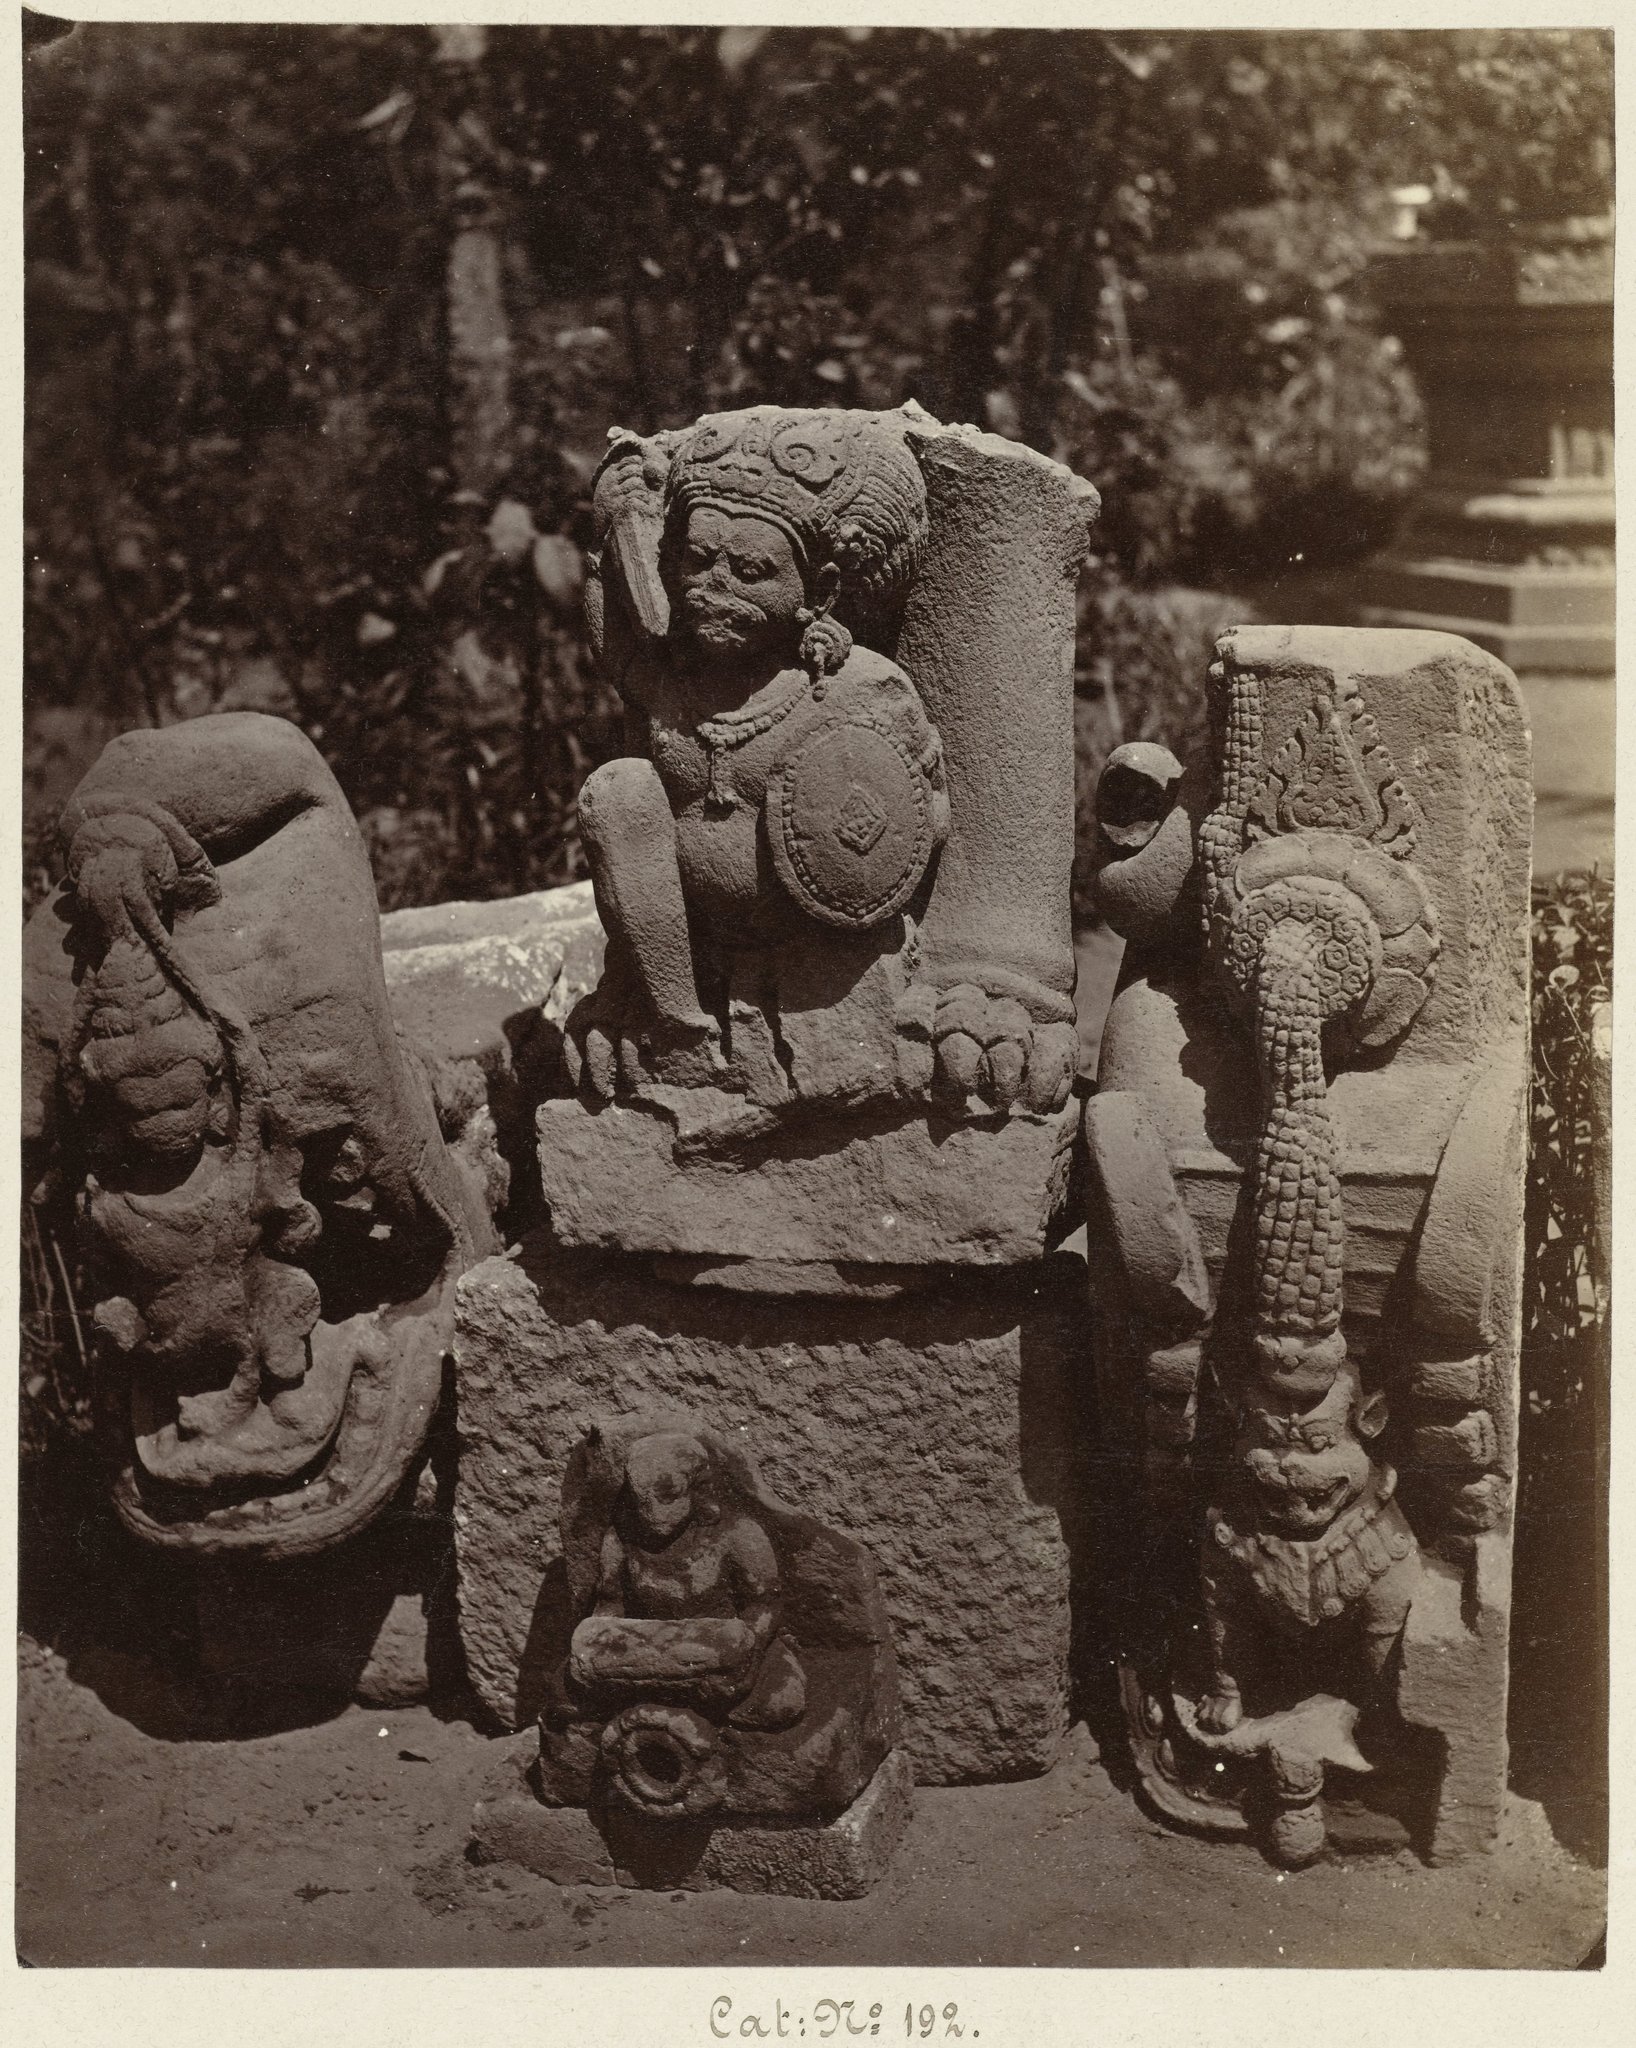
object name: photograph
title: Three waterspouts and a fighter between lion paws (former Lichte collection). Yogyakarta, Yogyakarta district, D.I. Yogyakarta province, 9th century.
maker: isidore kinsbergen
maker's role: fotograaf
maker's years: 1821-1905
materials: cardboard, paper, photographic support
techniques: albumen print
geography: java